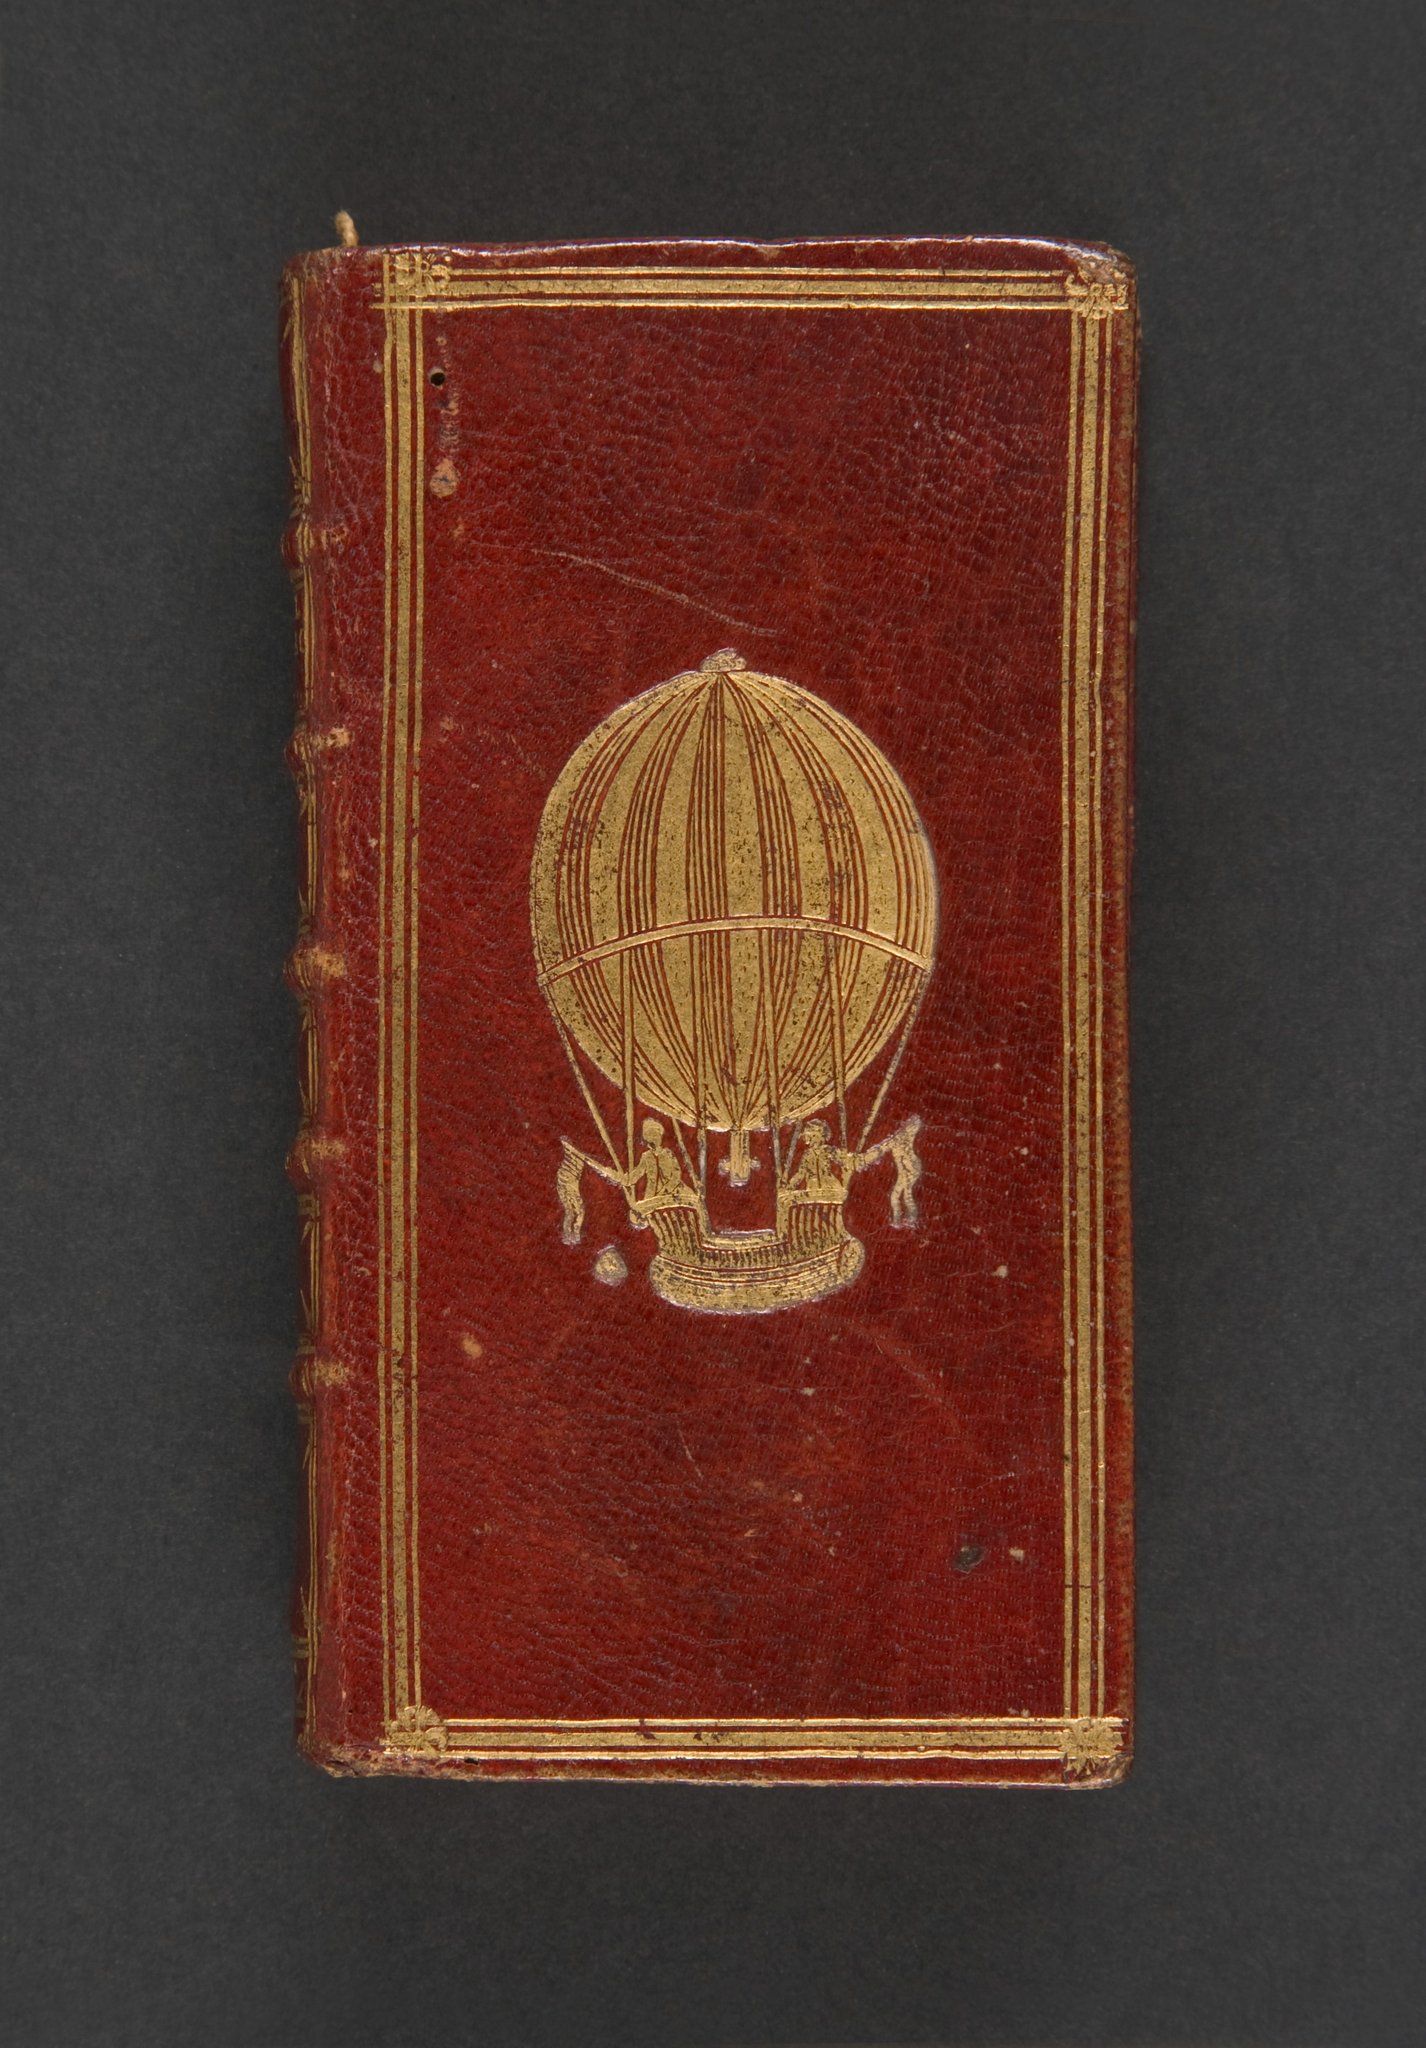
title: Almanach royal, année bissextile M.DCC.LXXXIV.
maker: laurent charles d' houry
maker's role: publisher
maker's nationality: french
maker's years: 1717-1786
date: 1783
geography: france